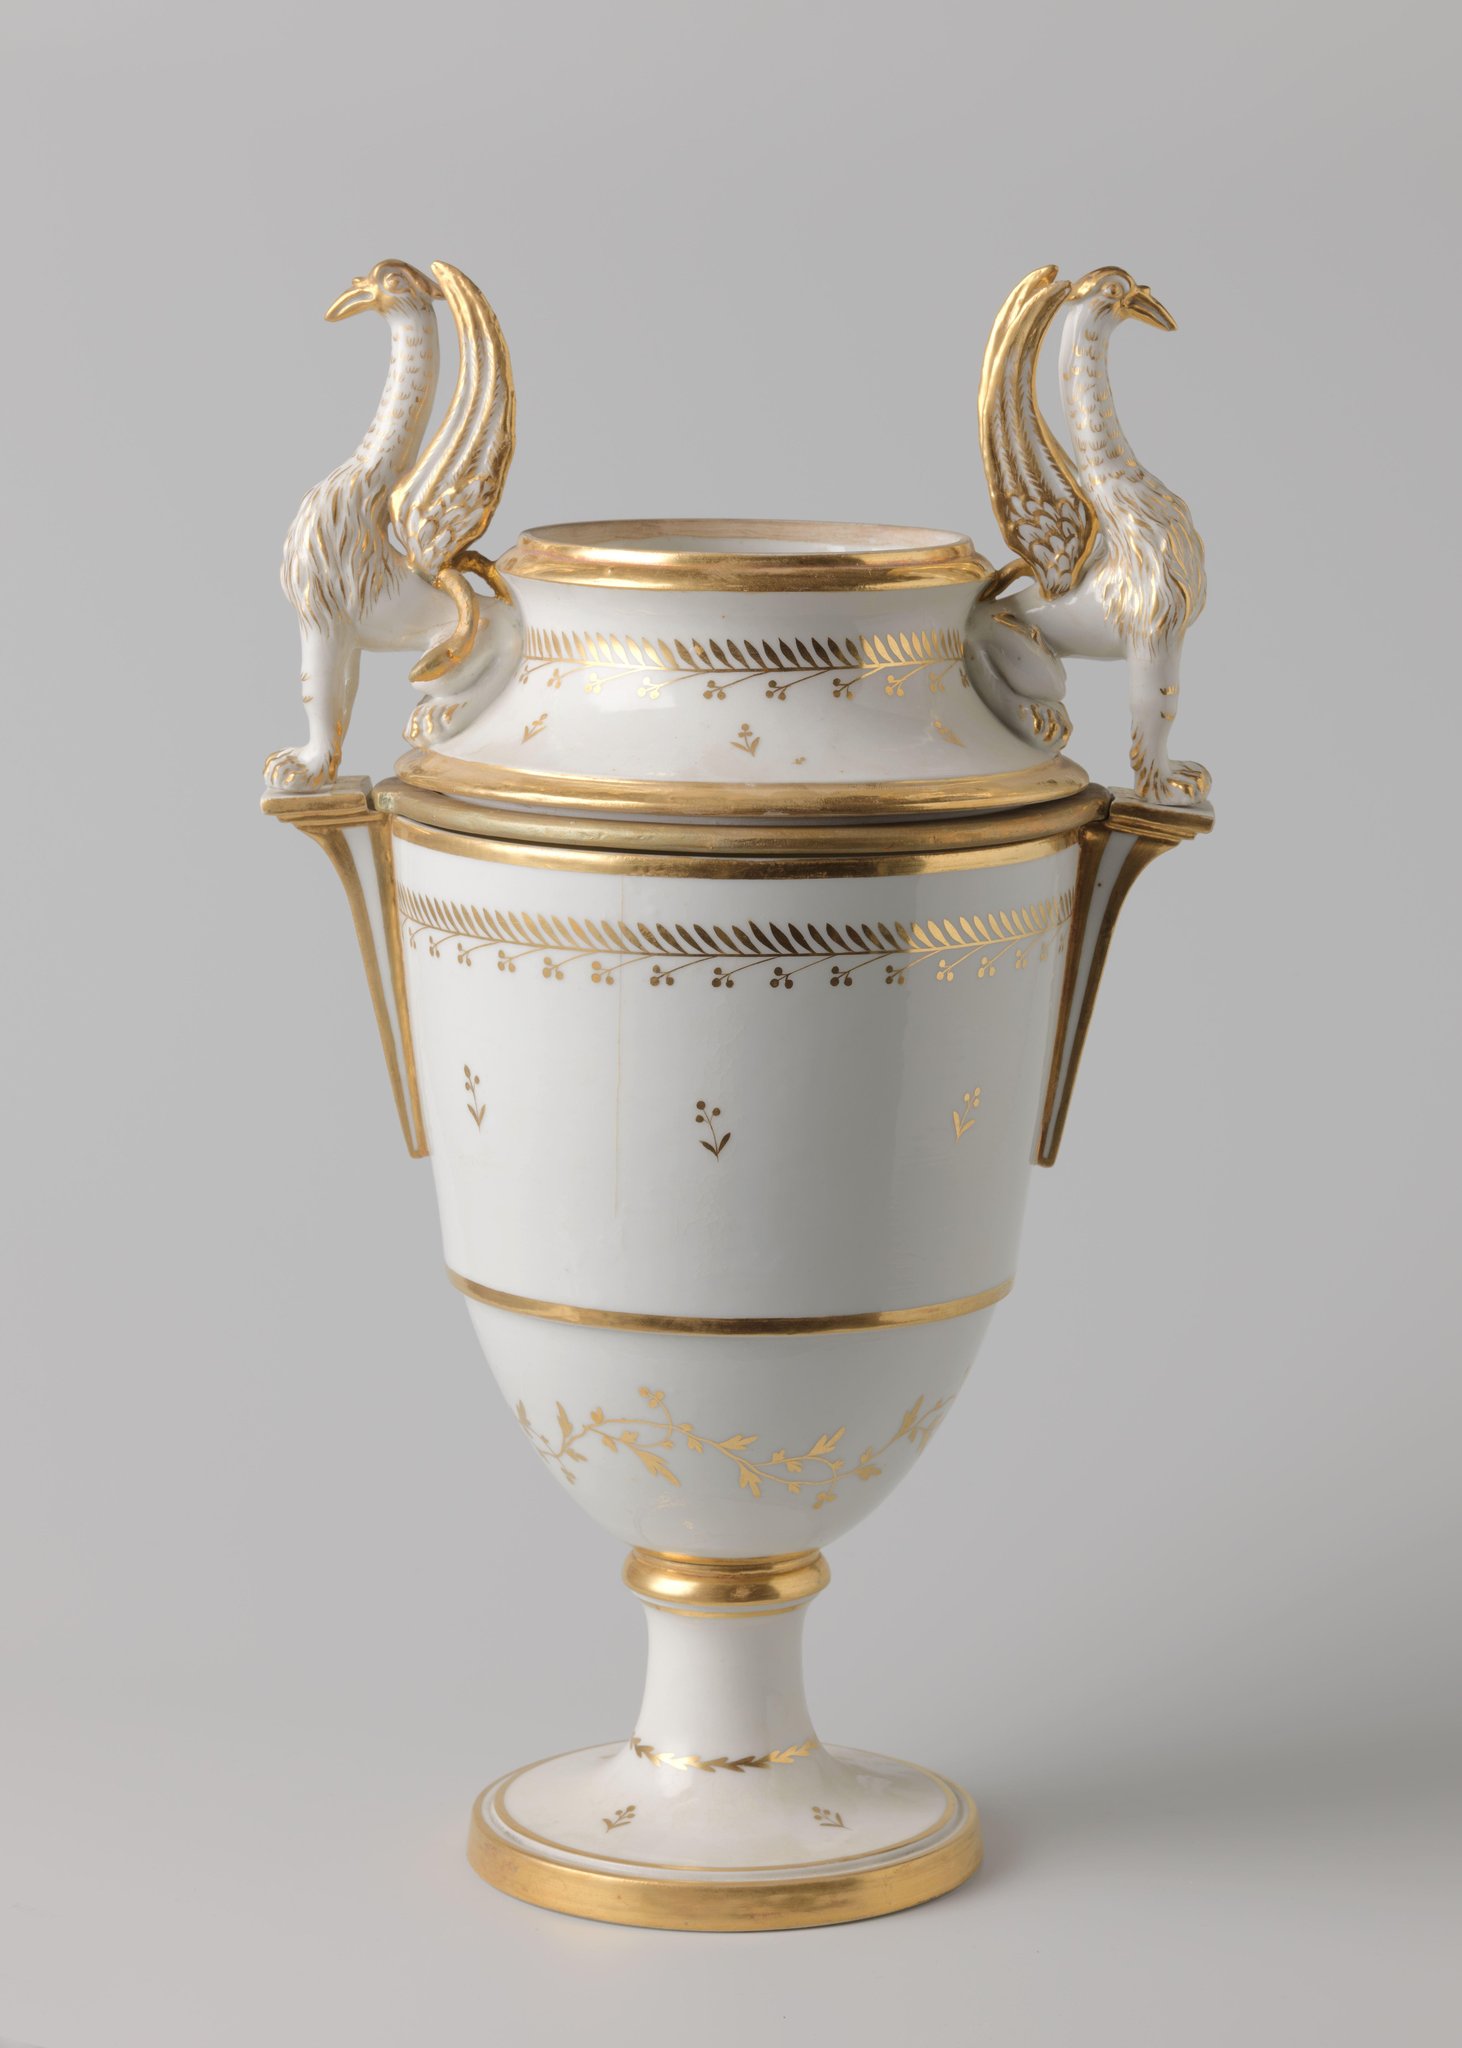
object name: kastanjevaas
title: Bak van kastanjevaas versierd met griffioenen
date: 1810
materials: porcelain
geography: netherlands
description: Bak van kastanjevaas waarvan de oren de vorm van griffioenen heeft.